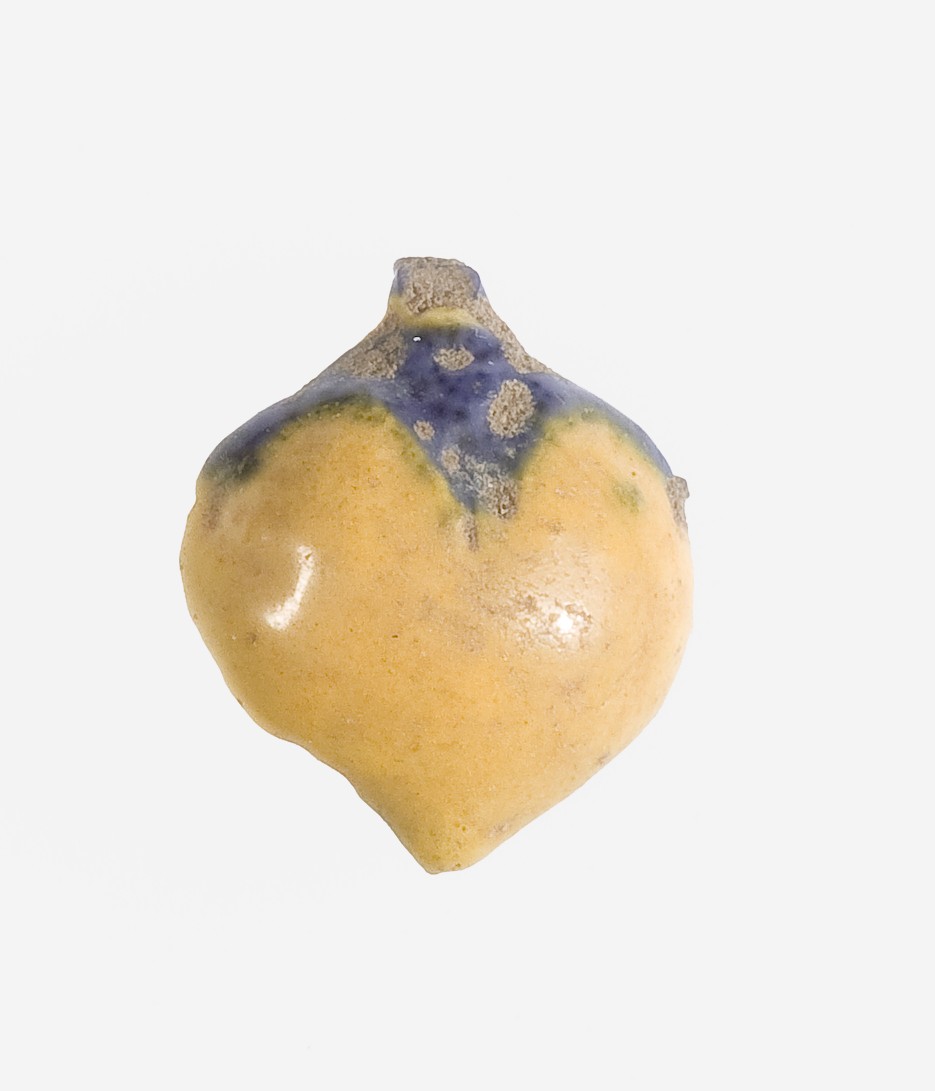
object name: pendant, persea fruit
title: Persea fruit pendant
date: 1390-1352 BCE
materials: faience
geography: egypt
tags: fruit